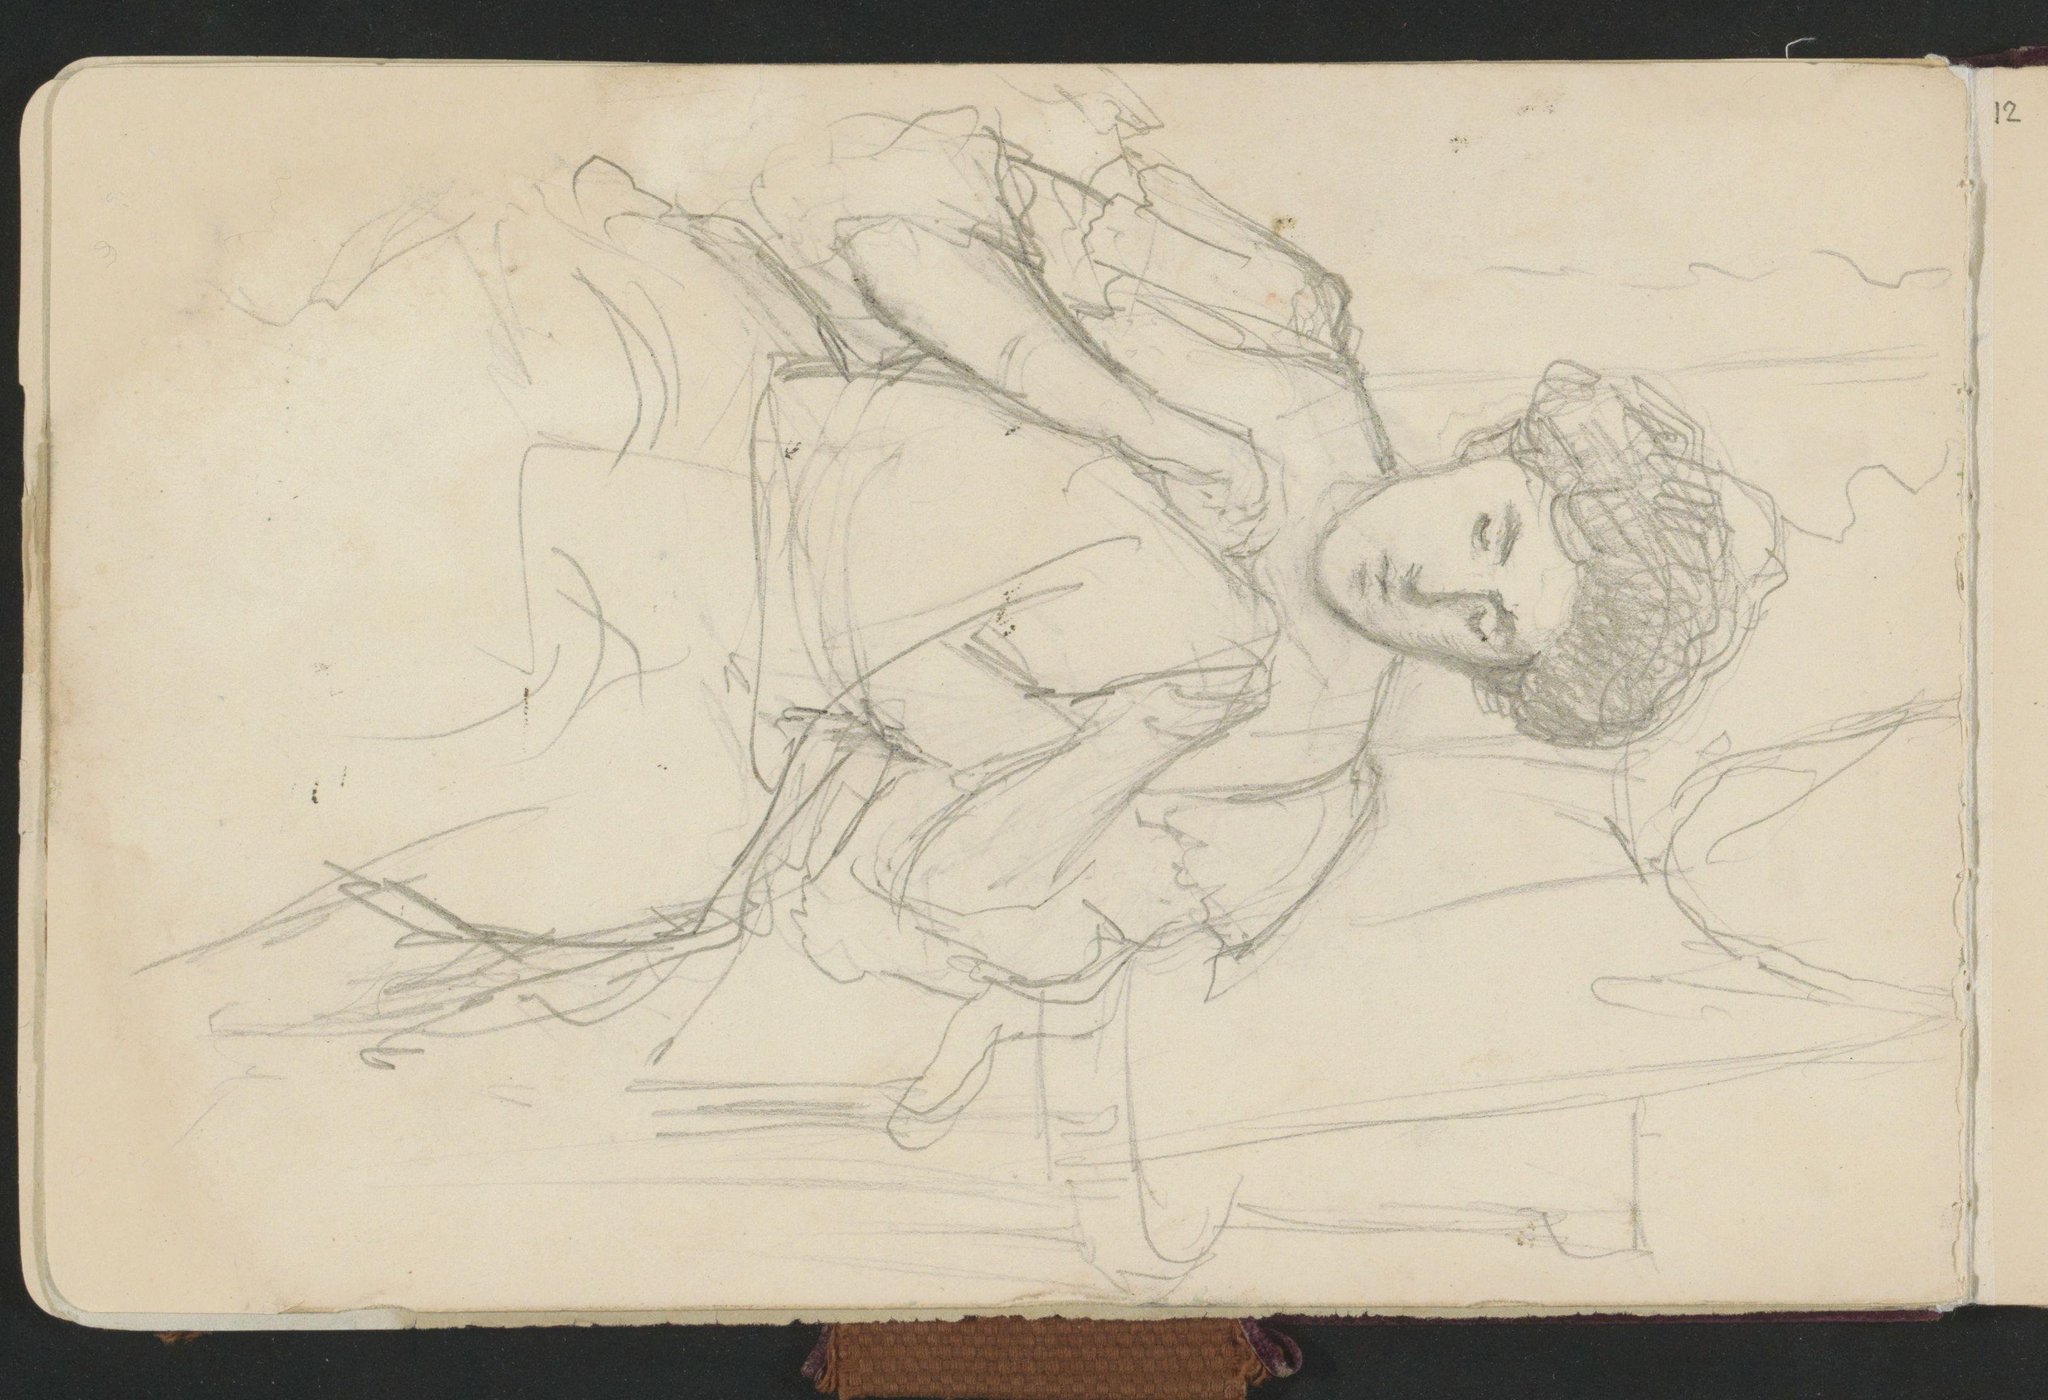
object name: sketchbook leaf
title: Handwerkende vrouw in een stoel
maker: jozef israëls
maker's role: draughtsman, painter, print maker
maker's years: 1824-1911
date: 1885-1911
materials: paper, pencil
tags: sitting figure, home sewing; repair of clothes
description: Blad 11 verso uit een schetsboek met 26 bladen.